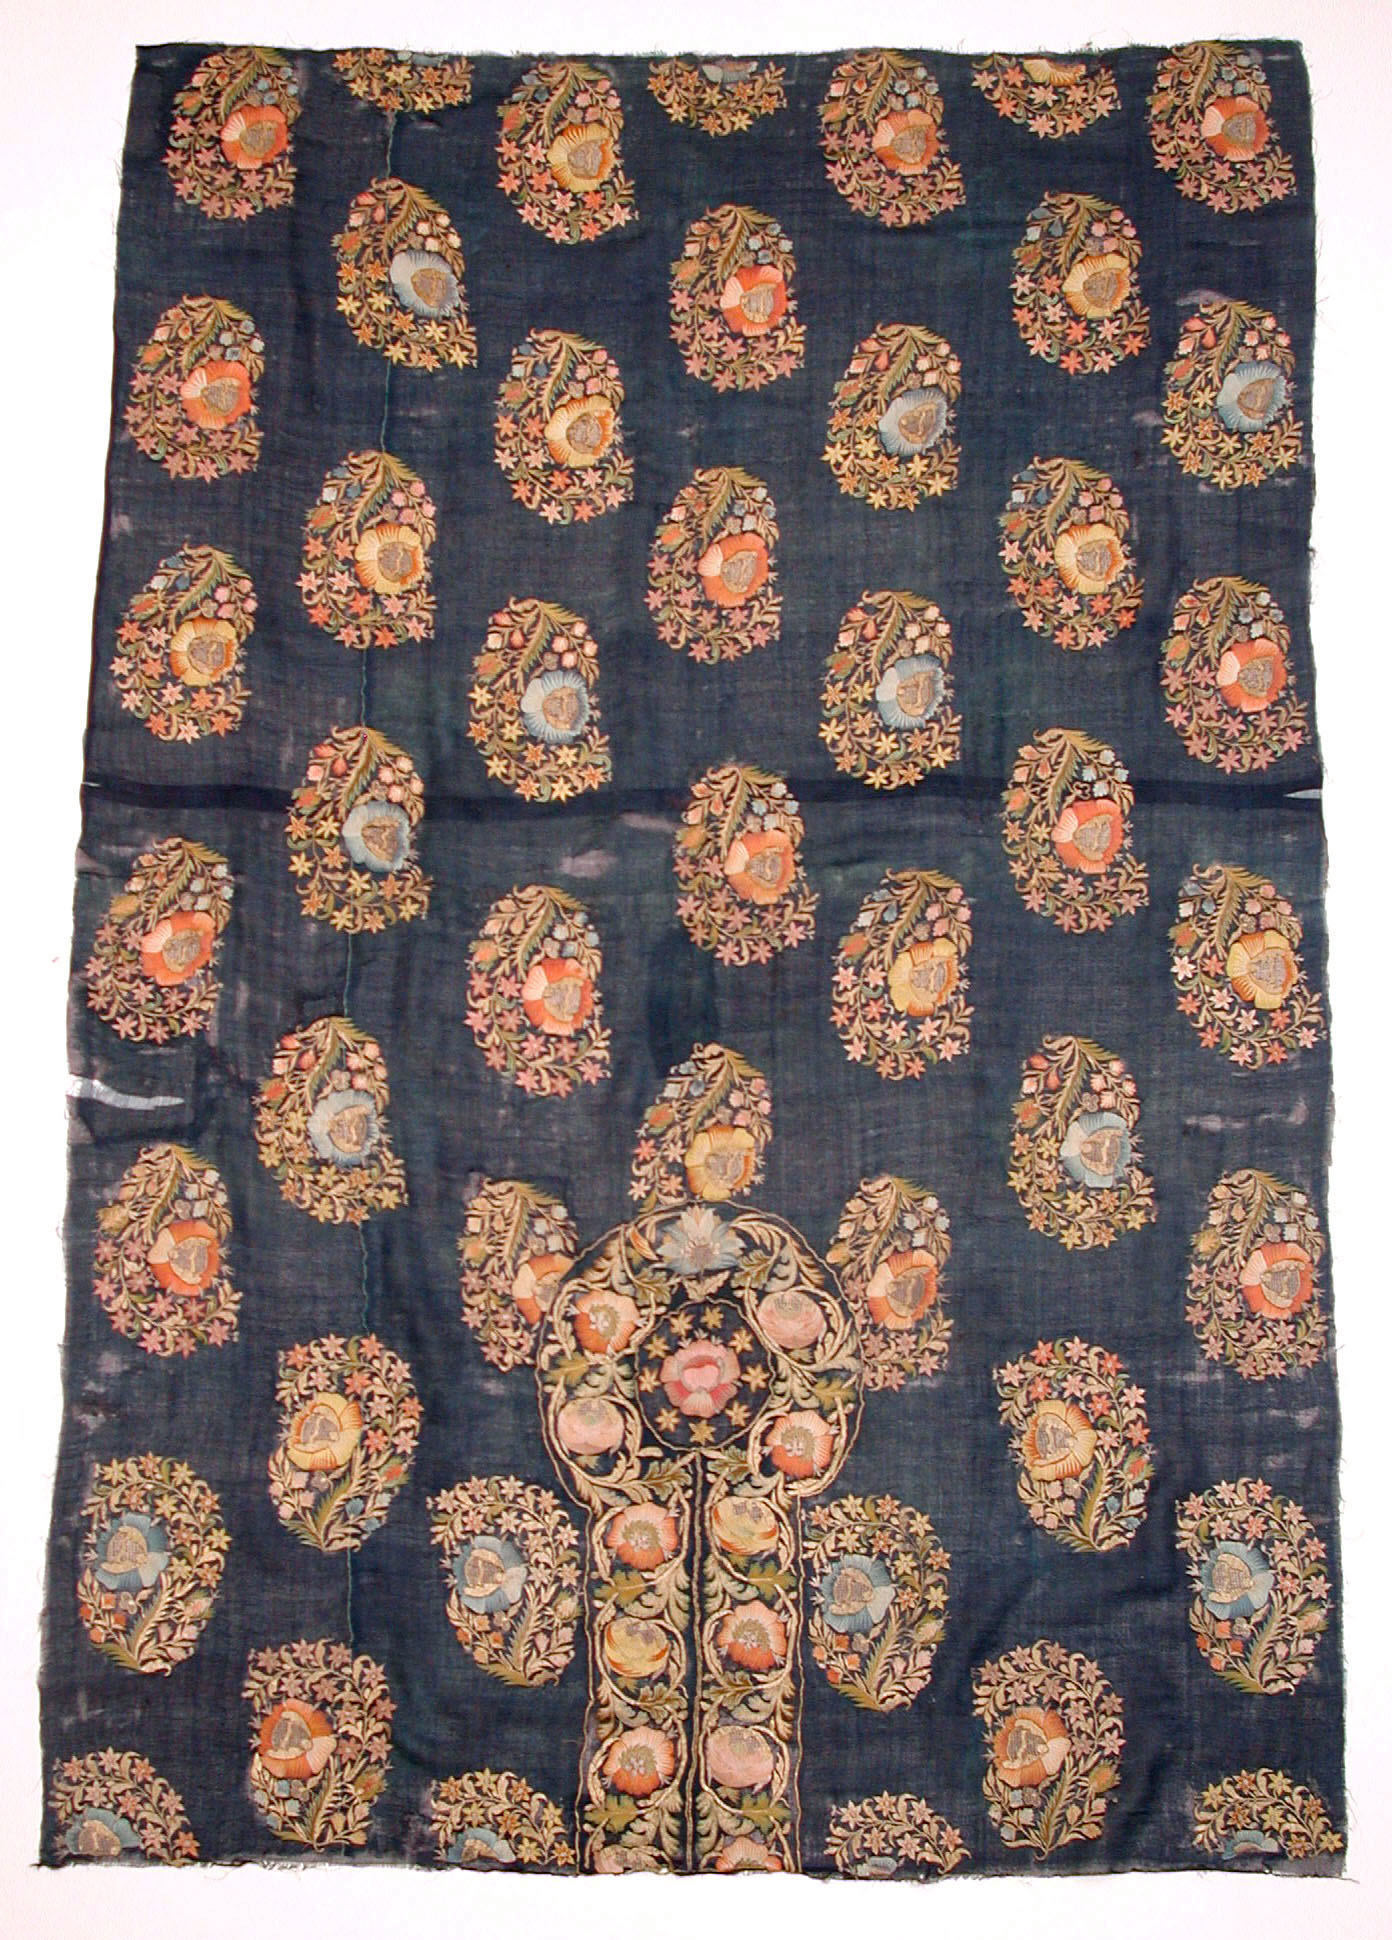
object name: apron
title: Barber's Apron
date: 1601-1800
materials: gold, silk, silver, thread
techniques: embroidery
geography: turkey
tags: flowers